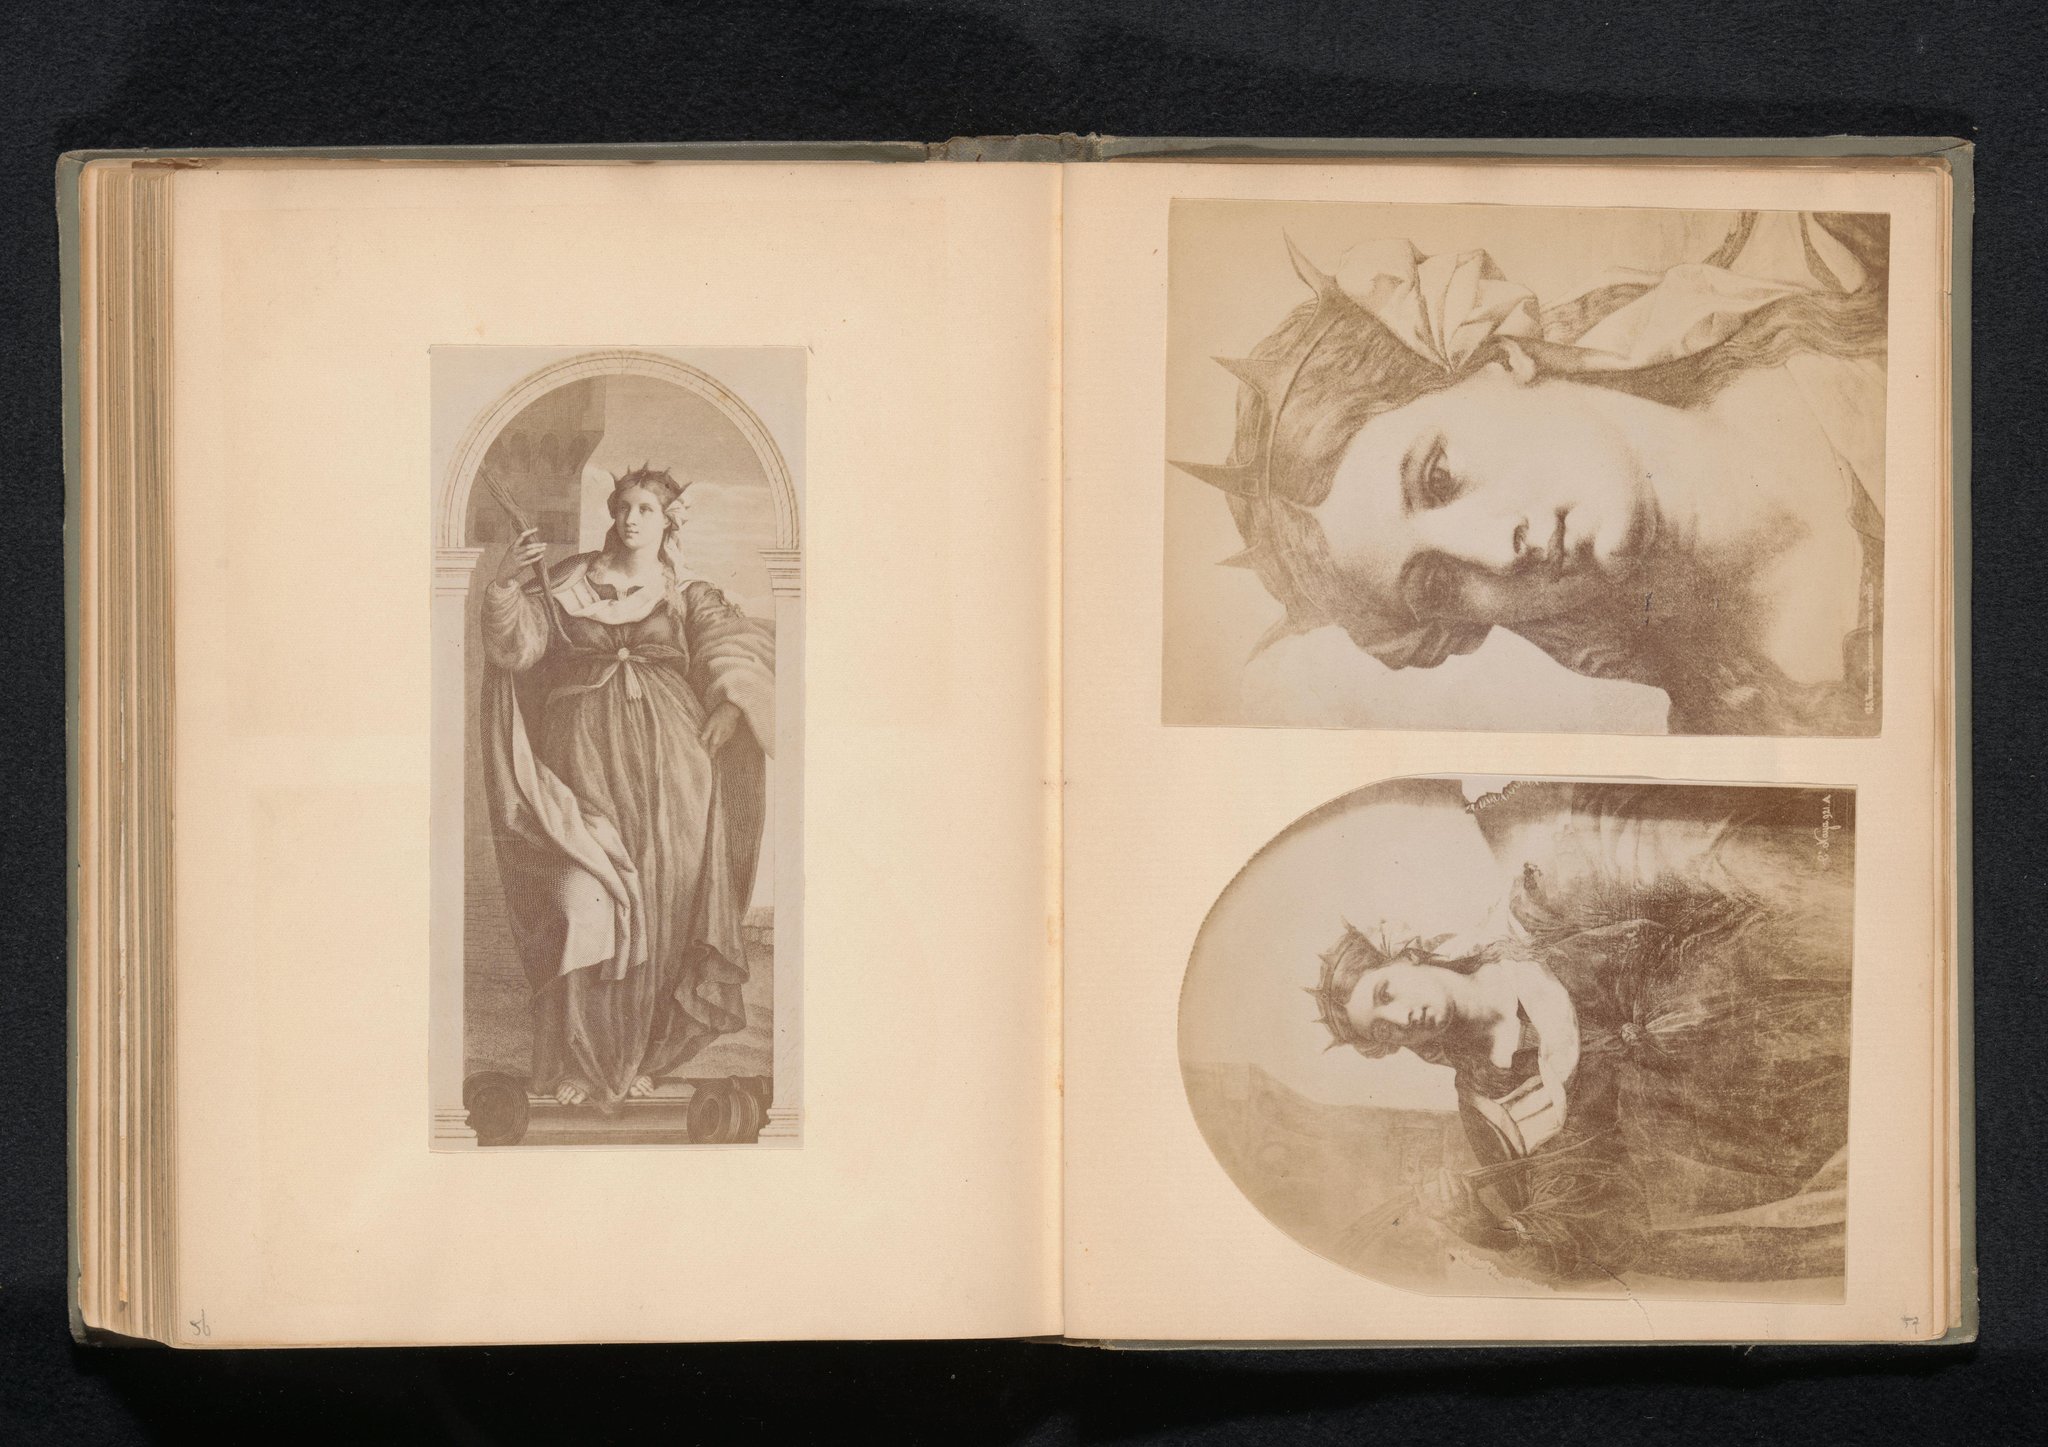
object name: page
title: Fotoreproductie van een prent naar een schilderij, voorstellende de heilige Barbara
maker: Anonymous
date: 1882-1887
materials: photographic support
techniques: albumen print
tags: the virgin martyr barbara; possible attributes: book, cannon(ball), crown, cross, chalice with wafer, dioscuros (her father), peacock feather, sword, torches, mason's tools, tower